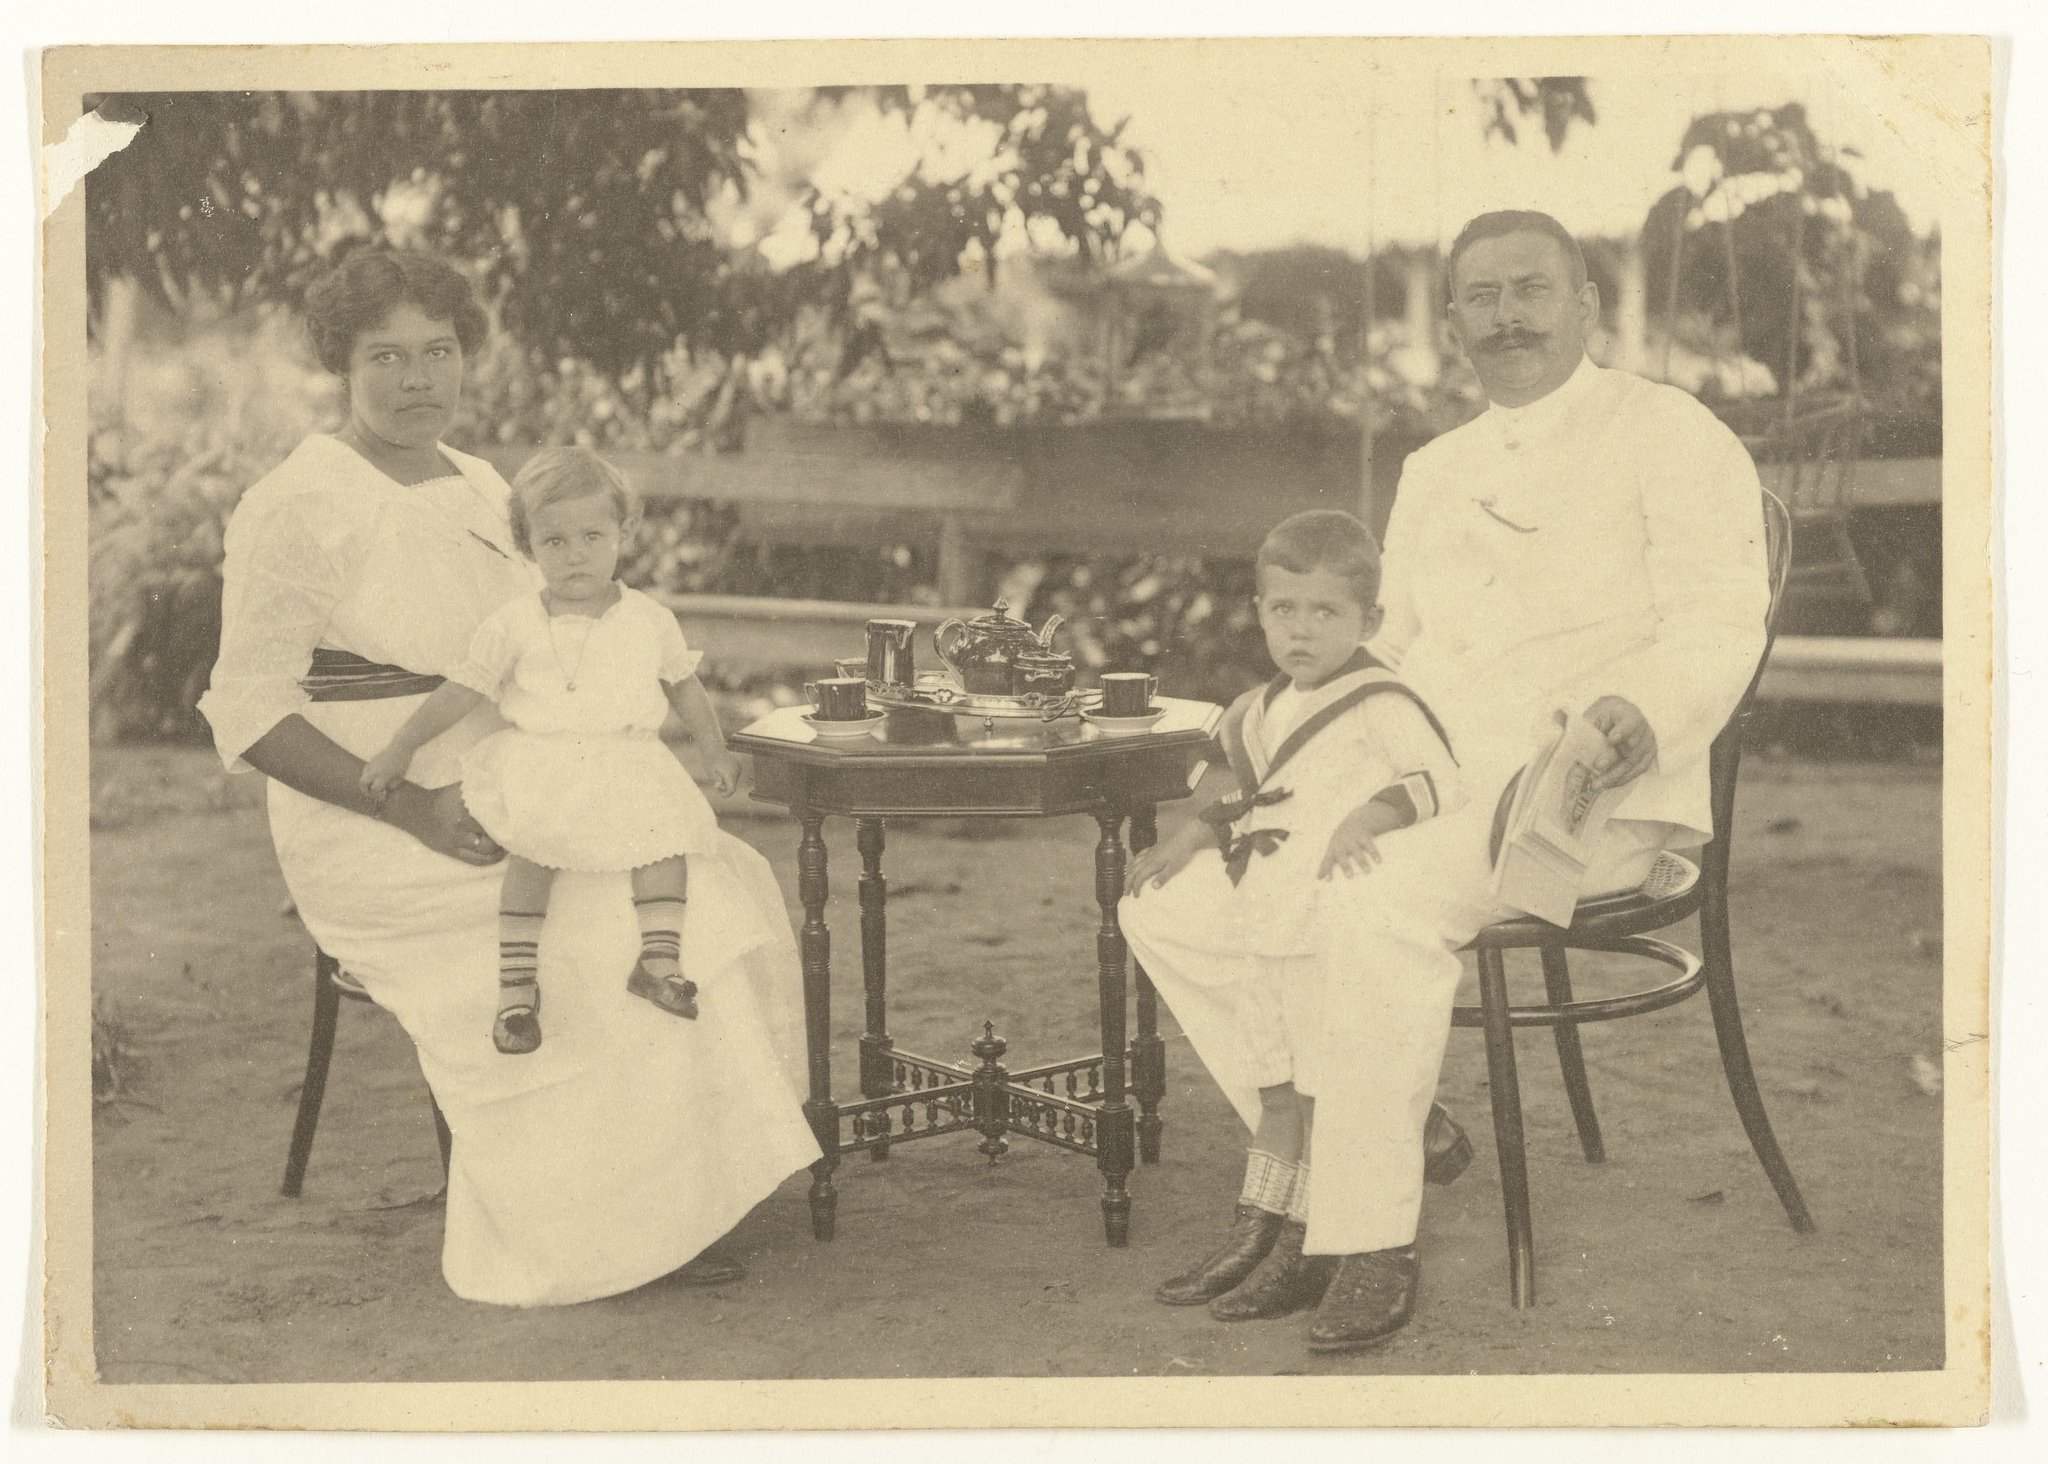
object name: photograph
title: Familie Brouwers drinkt thee op de plantage Accaribo, Suriname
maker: Anonymous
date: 1916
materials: photographic support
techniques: photography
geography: suriname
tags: haarlem, amsterdam, theodoor brouwers, family life at home, suriname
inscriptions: inscription: ‘Accaribo "16’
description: In de periode 1911-1932 woonde op plantage Accaribo in Suriname de familie Brouwers van wie de foto's afkomstig zijn. Rond 1910 vond Theodoor Brouwers werk op plantage Accaribo. In 1929 werd hij eigenaar van de plantage.